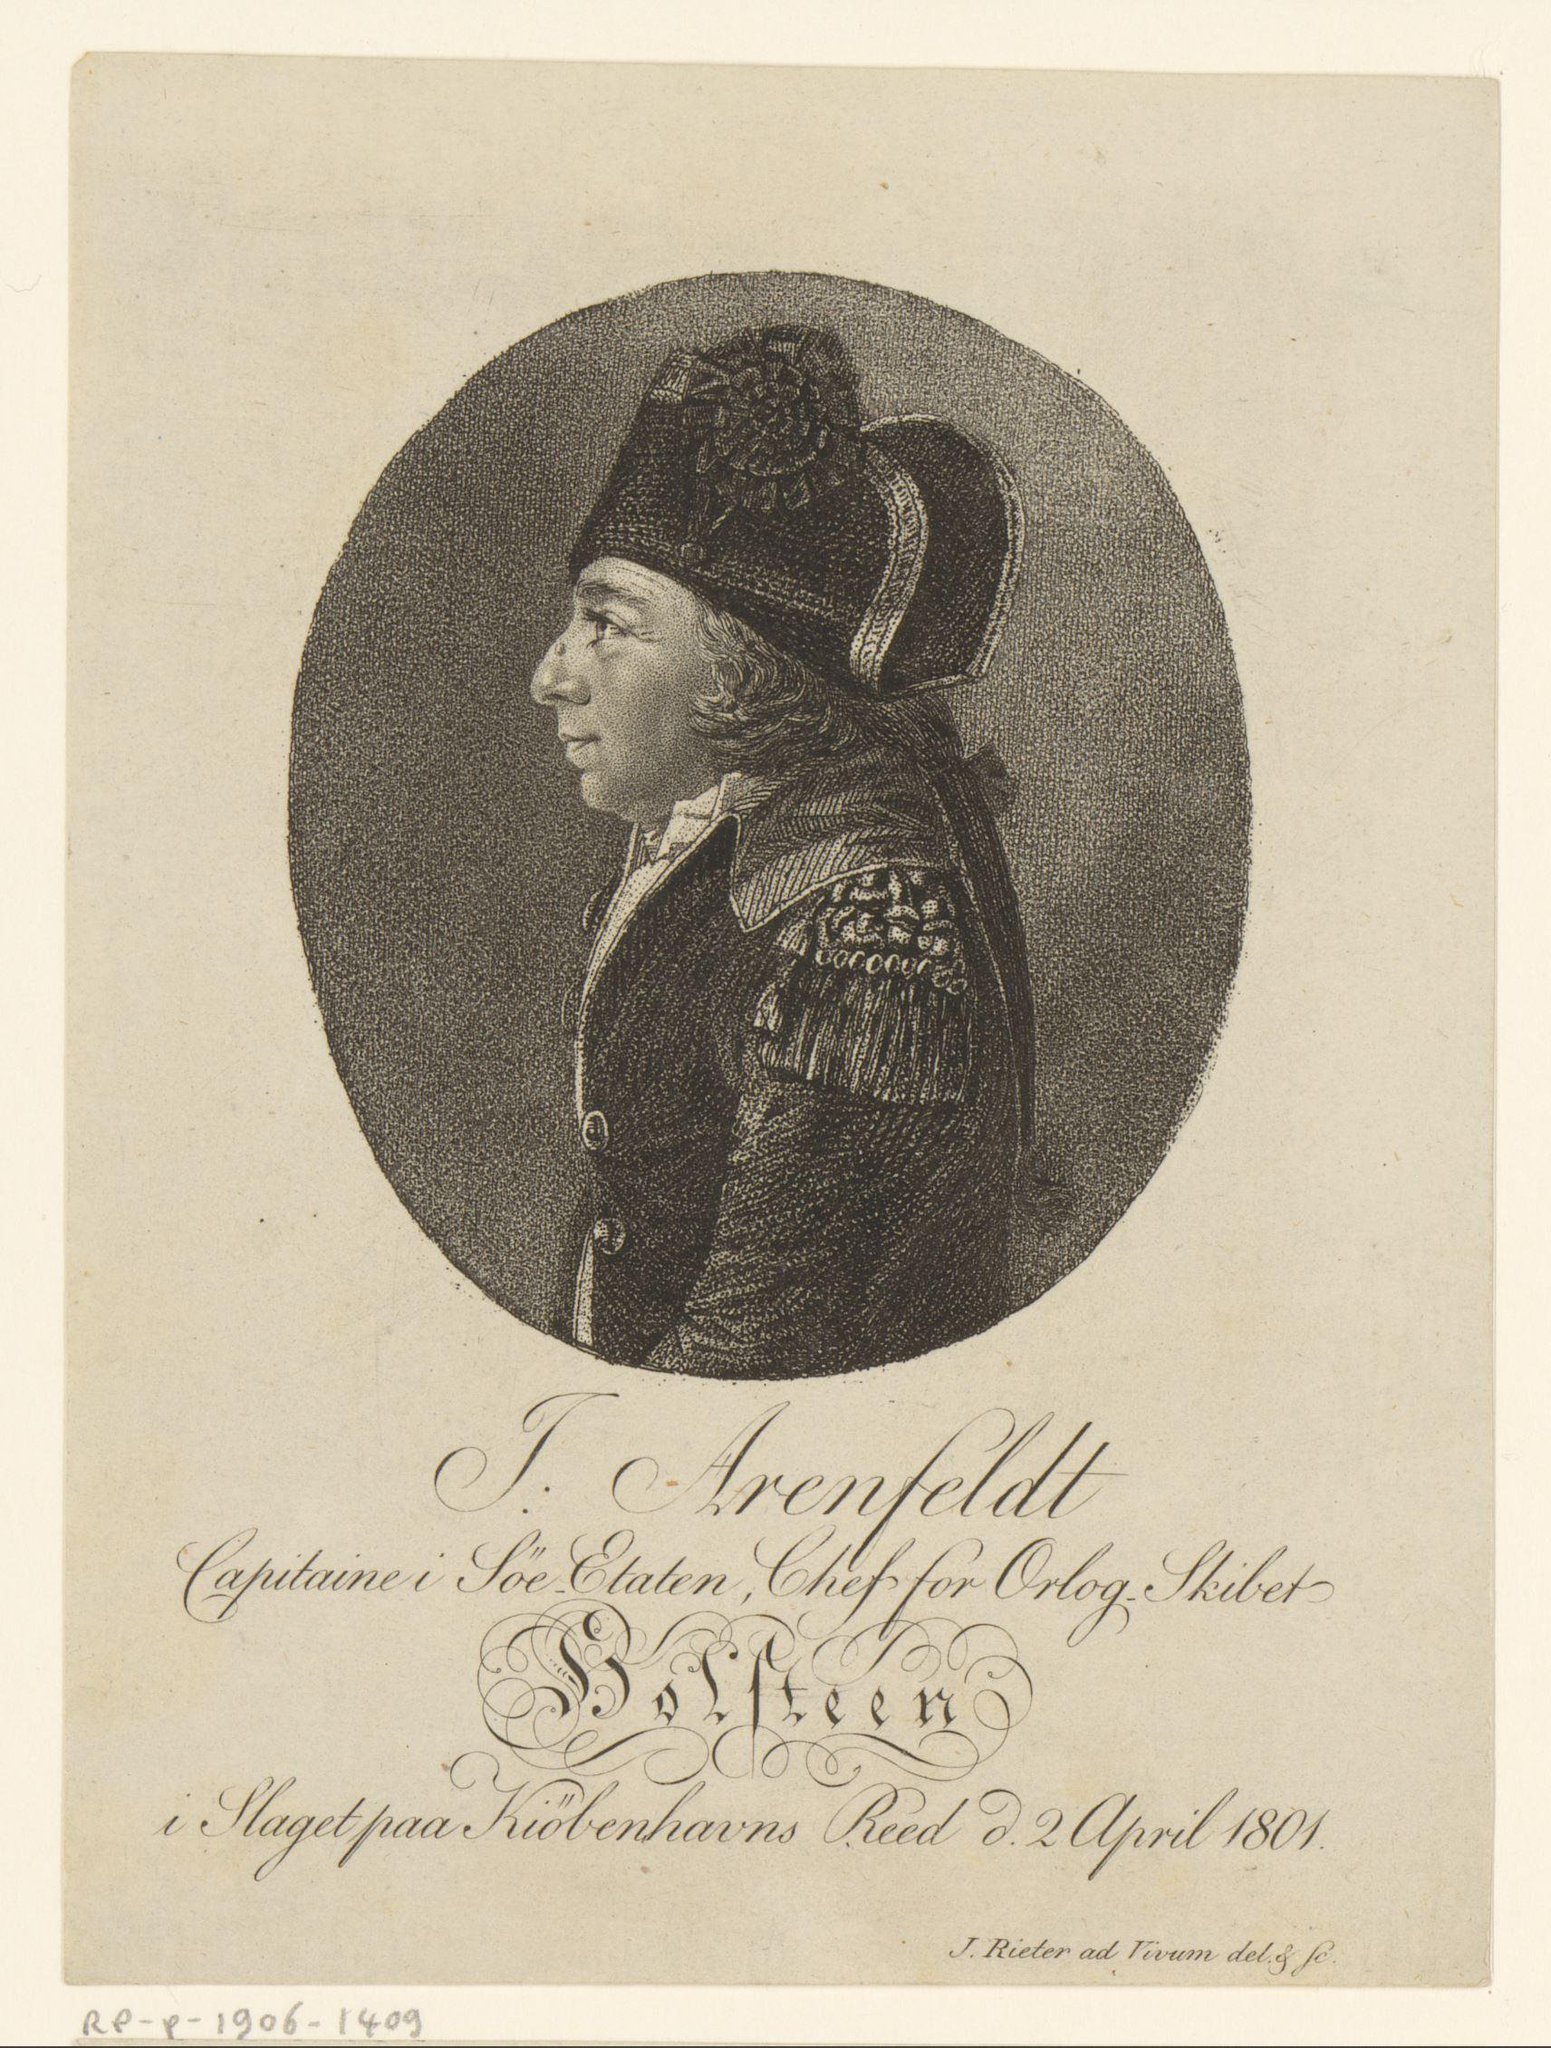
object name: print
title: Portret van J. Arenfeldt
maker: johann jakob rieter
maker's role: print maker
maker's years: 1758-1823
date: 1801-1823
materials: paper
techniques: engraving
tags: historical persons, the soldier; the soldier's life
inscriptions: collector's mark: Lugt 2228